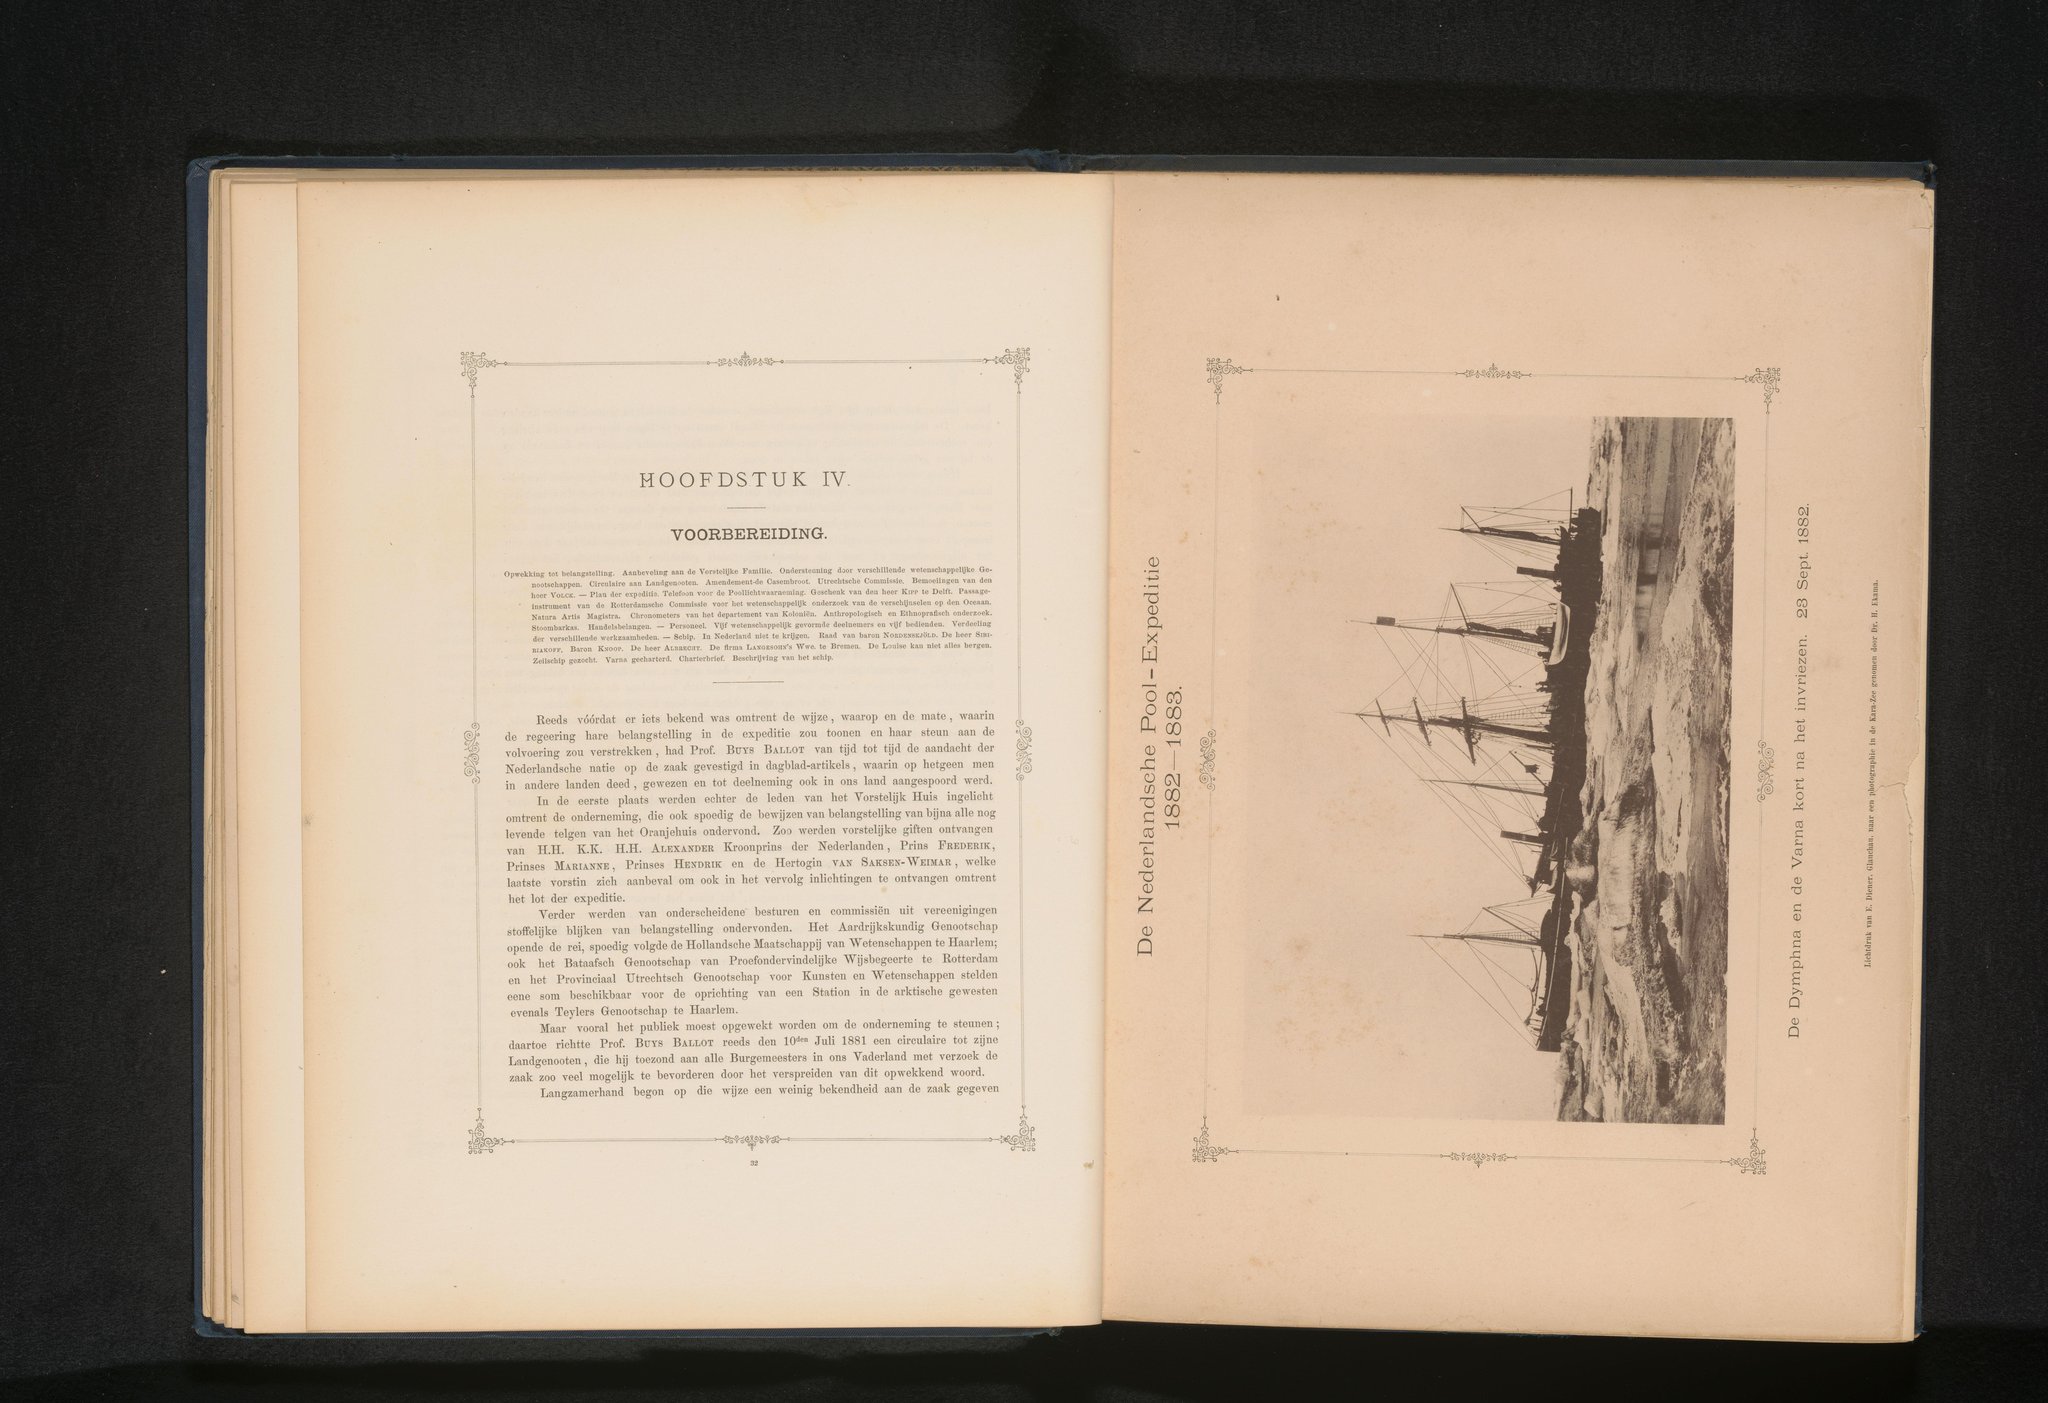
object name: photomechanical print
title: De Dymphna en de Varna kort na het invriezen. 23. Sept. 1882.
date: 1881-1886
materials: paper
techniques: photograph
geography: glauchau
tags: ships (in general), landscapes in polar regions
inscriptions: inscription: ‘De Nederlandsche Pool-Expeditie 1882-1883.’